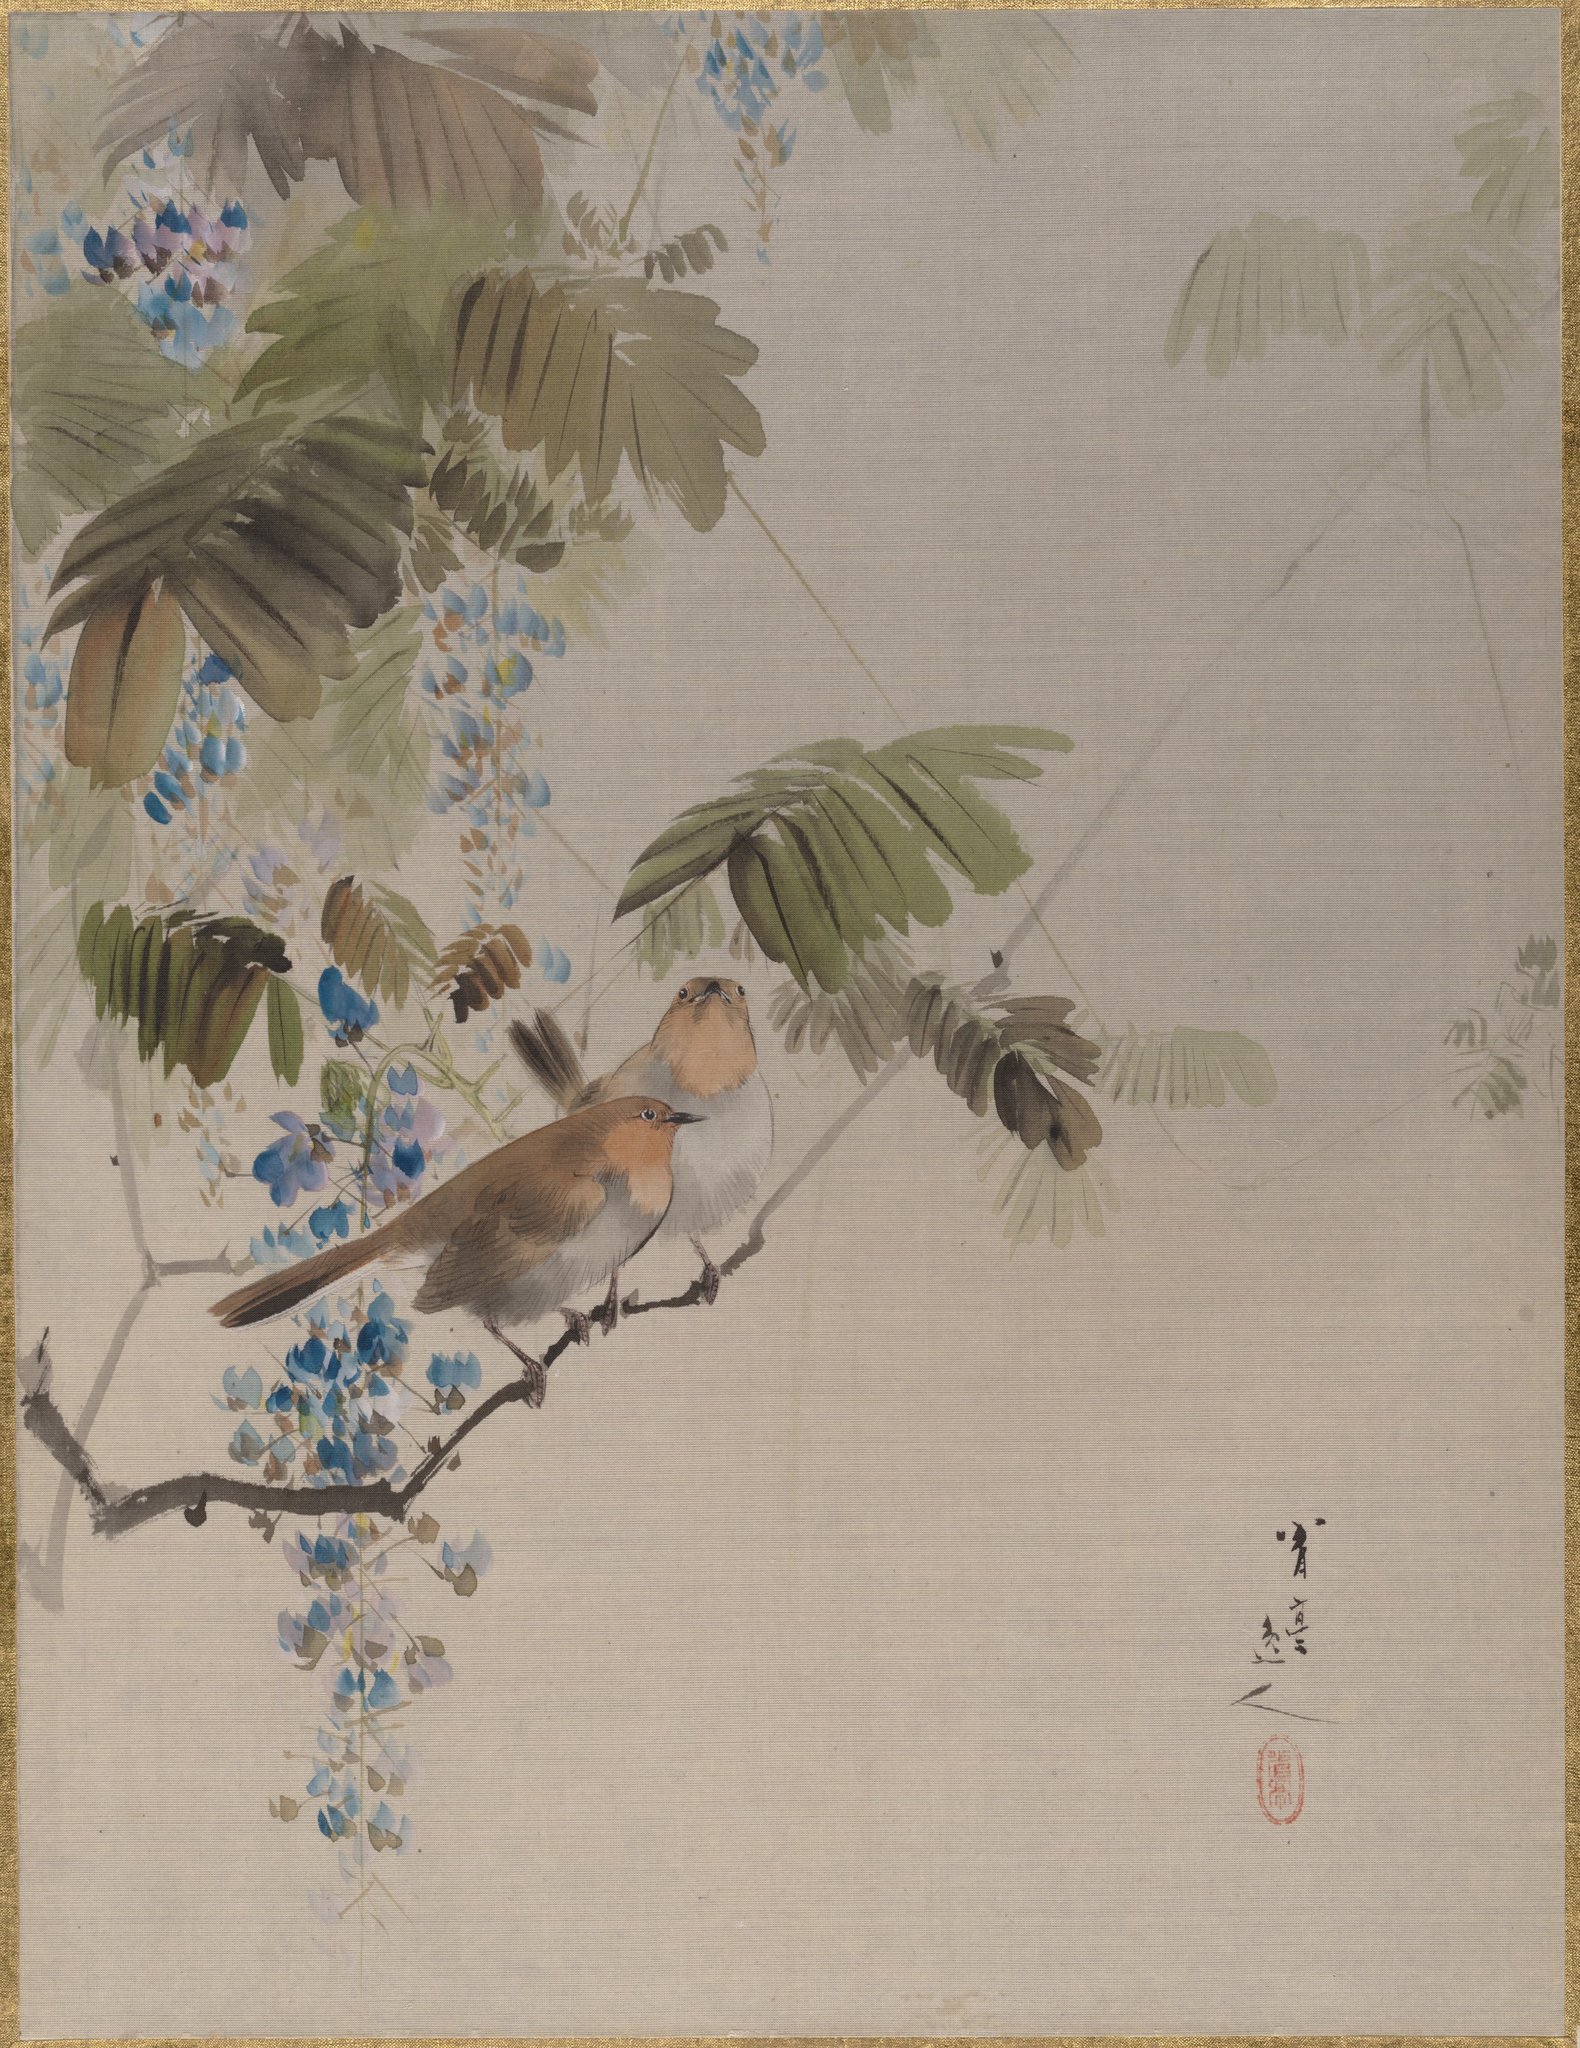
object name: album leaf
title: Birds and Flowers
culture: japanese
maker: watanabe seitei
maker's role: artist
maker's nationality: japanese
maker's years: 1851-1918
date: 1887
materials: ink, silk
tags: birds,flowers